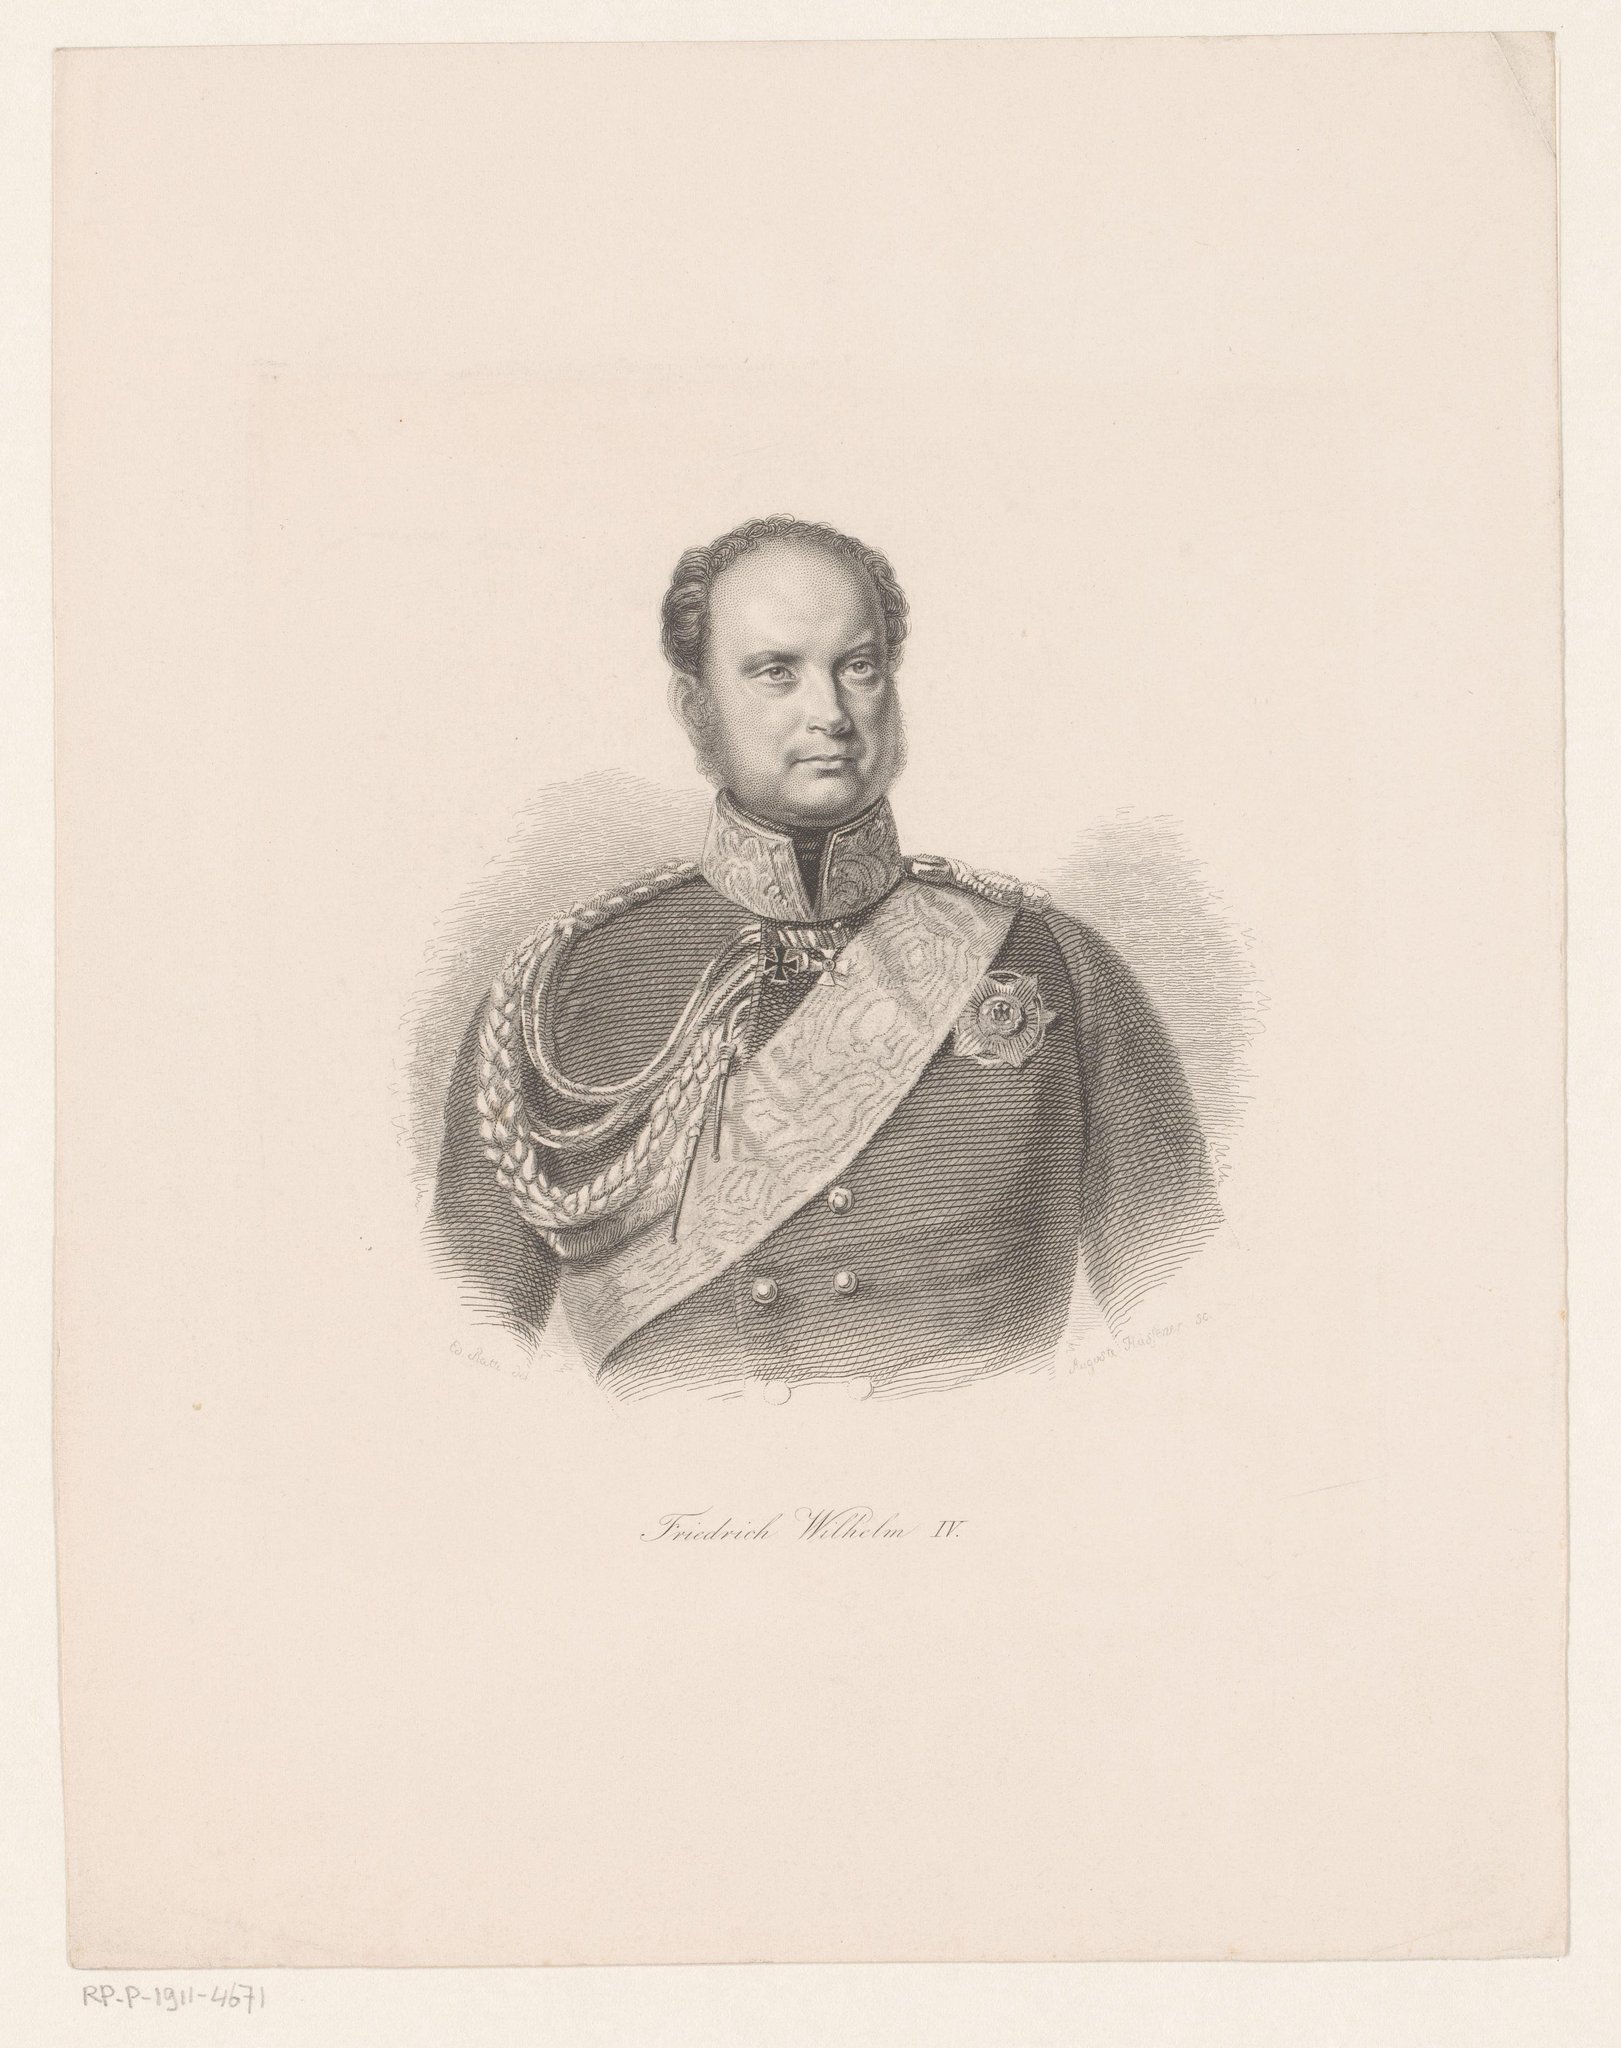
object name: print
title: Portret van Frederik Willem IV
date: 1826-1877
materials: paper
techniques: engraving, etching, intaglio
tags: frederik willem iv (koning van pruisen), knighthood order: teutonic order - insignia of a knighthood order, e.g.: badge, chain (with name of order), knighthood order (red eagle order), historical persons, king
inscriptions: collector's mark: Lugt 2228